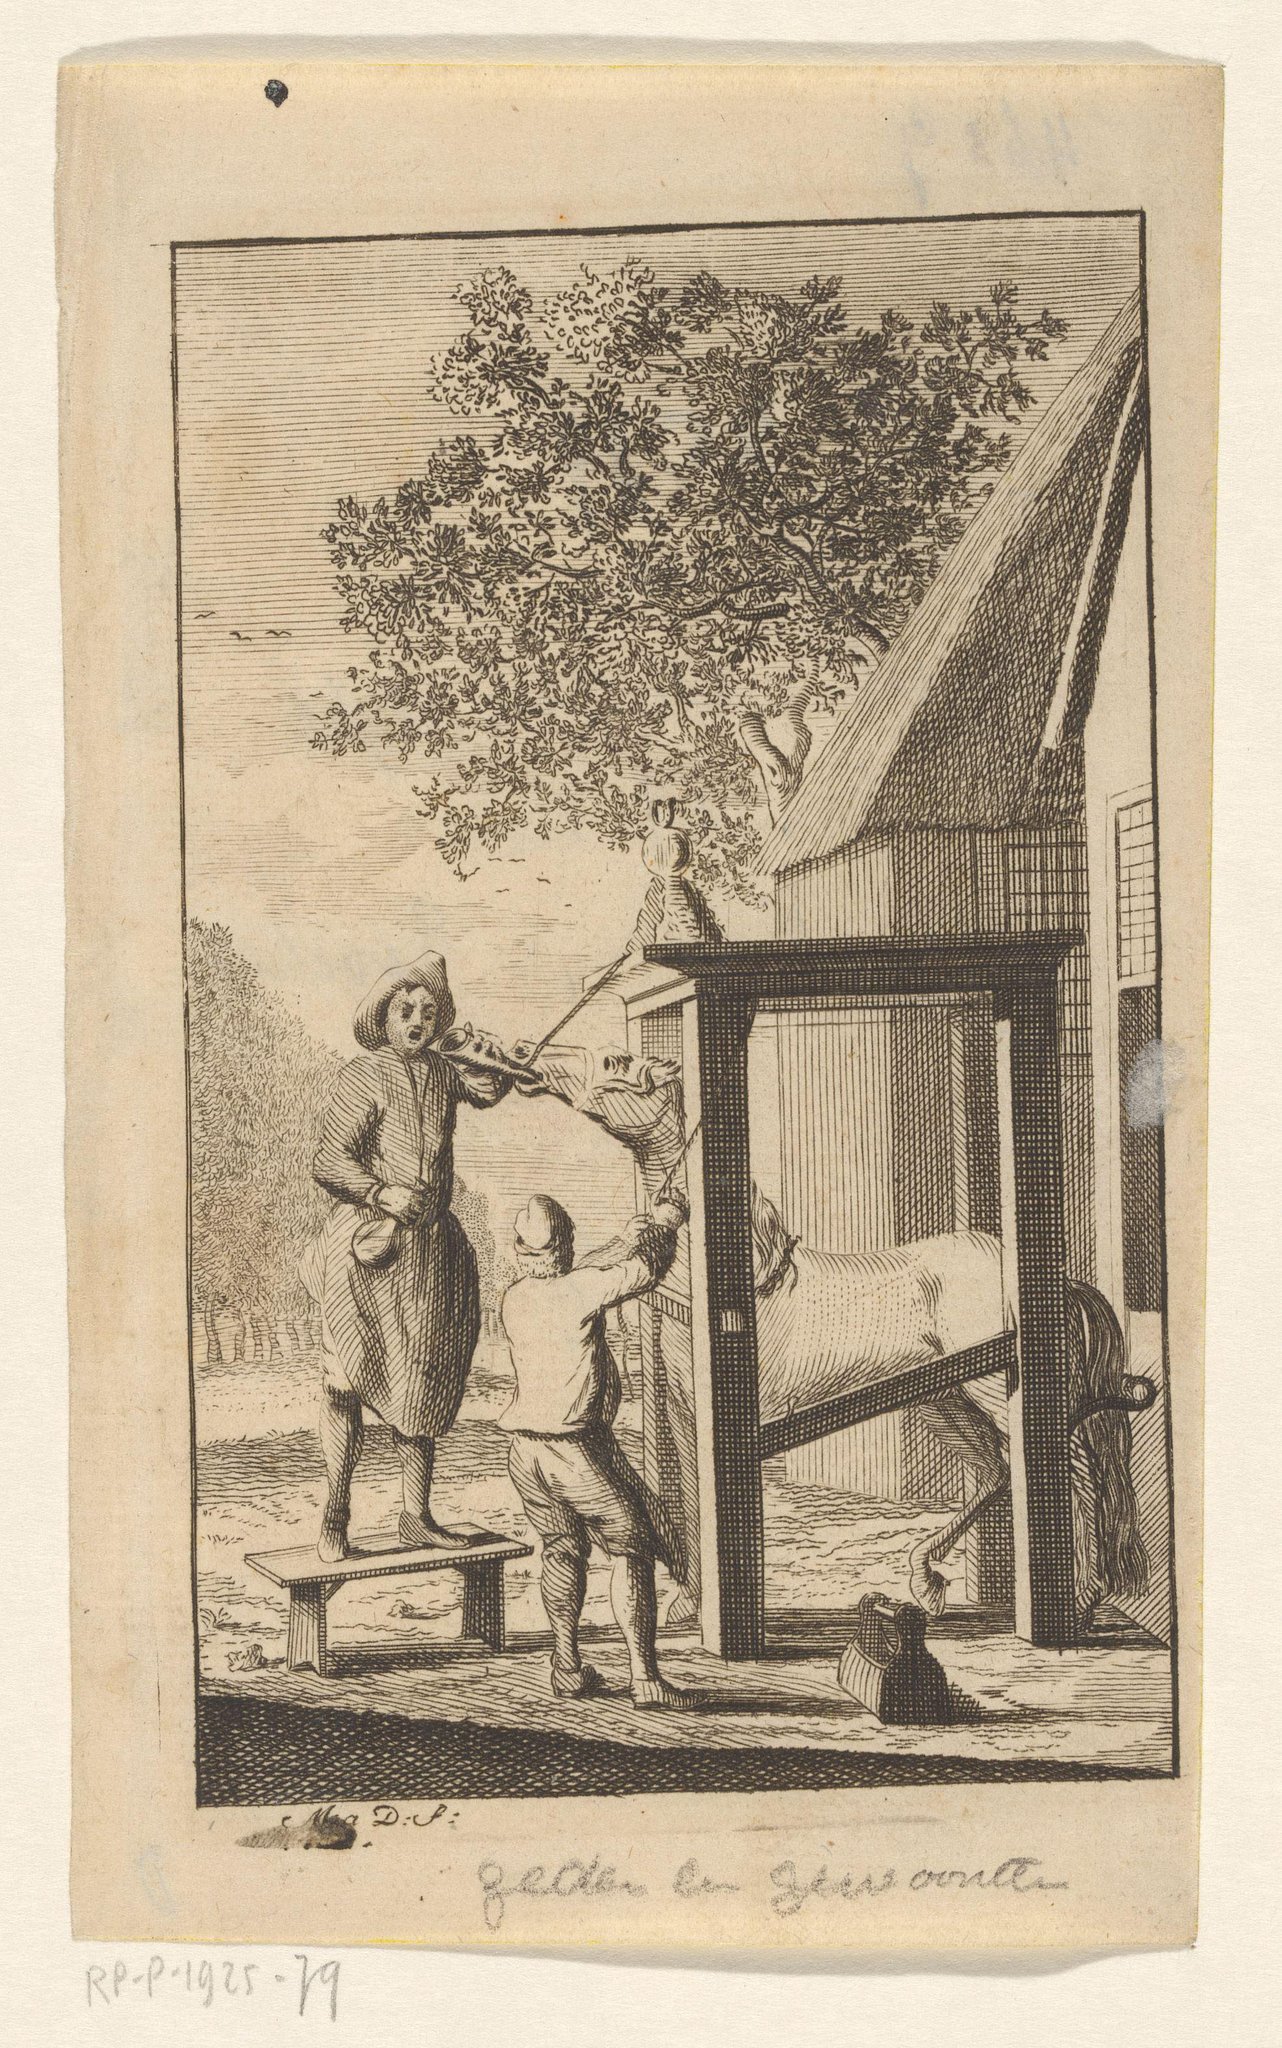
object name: titelblad, titelpagina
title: Titelpagina voor: De volmaakte princelyke hoef-smidt, paerde-kooper en stal-meester, 1750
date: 1750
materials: paper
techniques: engraving, etching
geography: amsterdam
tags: farrier, shoeing-smith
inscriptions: collector's mark: Lugt 2233, initials: ‘M:a D : f:’, collector's mark: Lugt 2228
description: Titelpagina voor: De volmaakte princelyke hoef-smidt, paerde-kooper en stal-meester. Amsterdam: Steven van Esveldt, 1750.